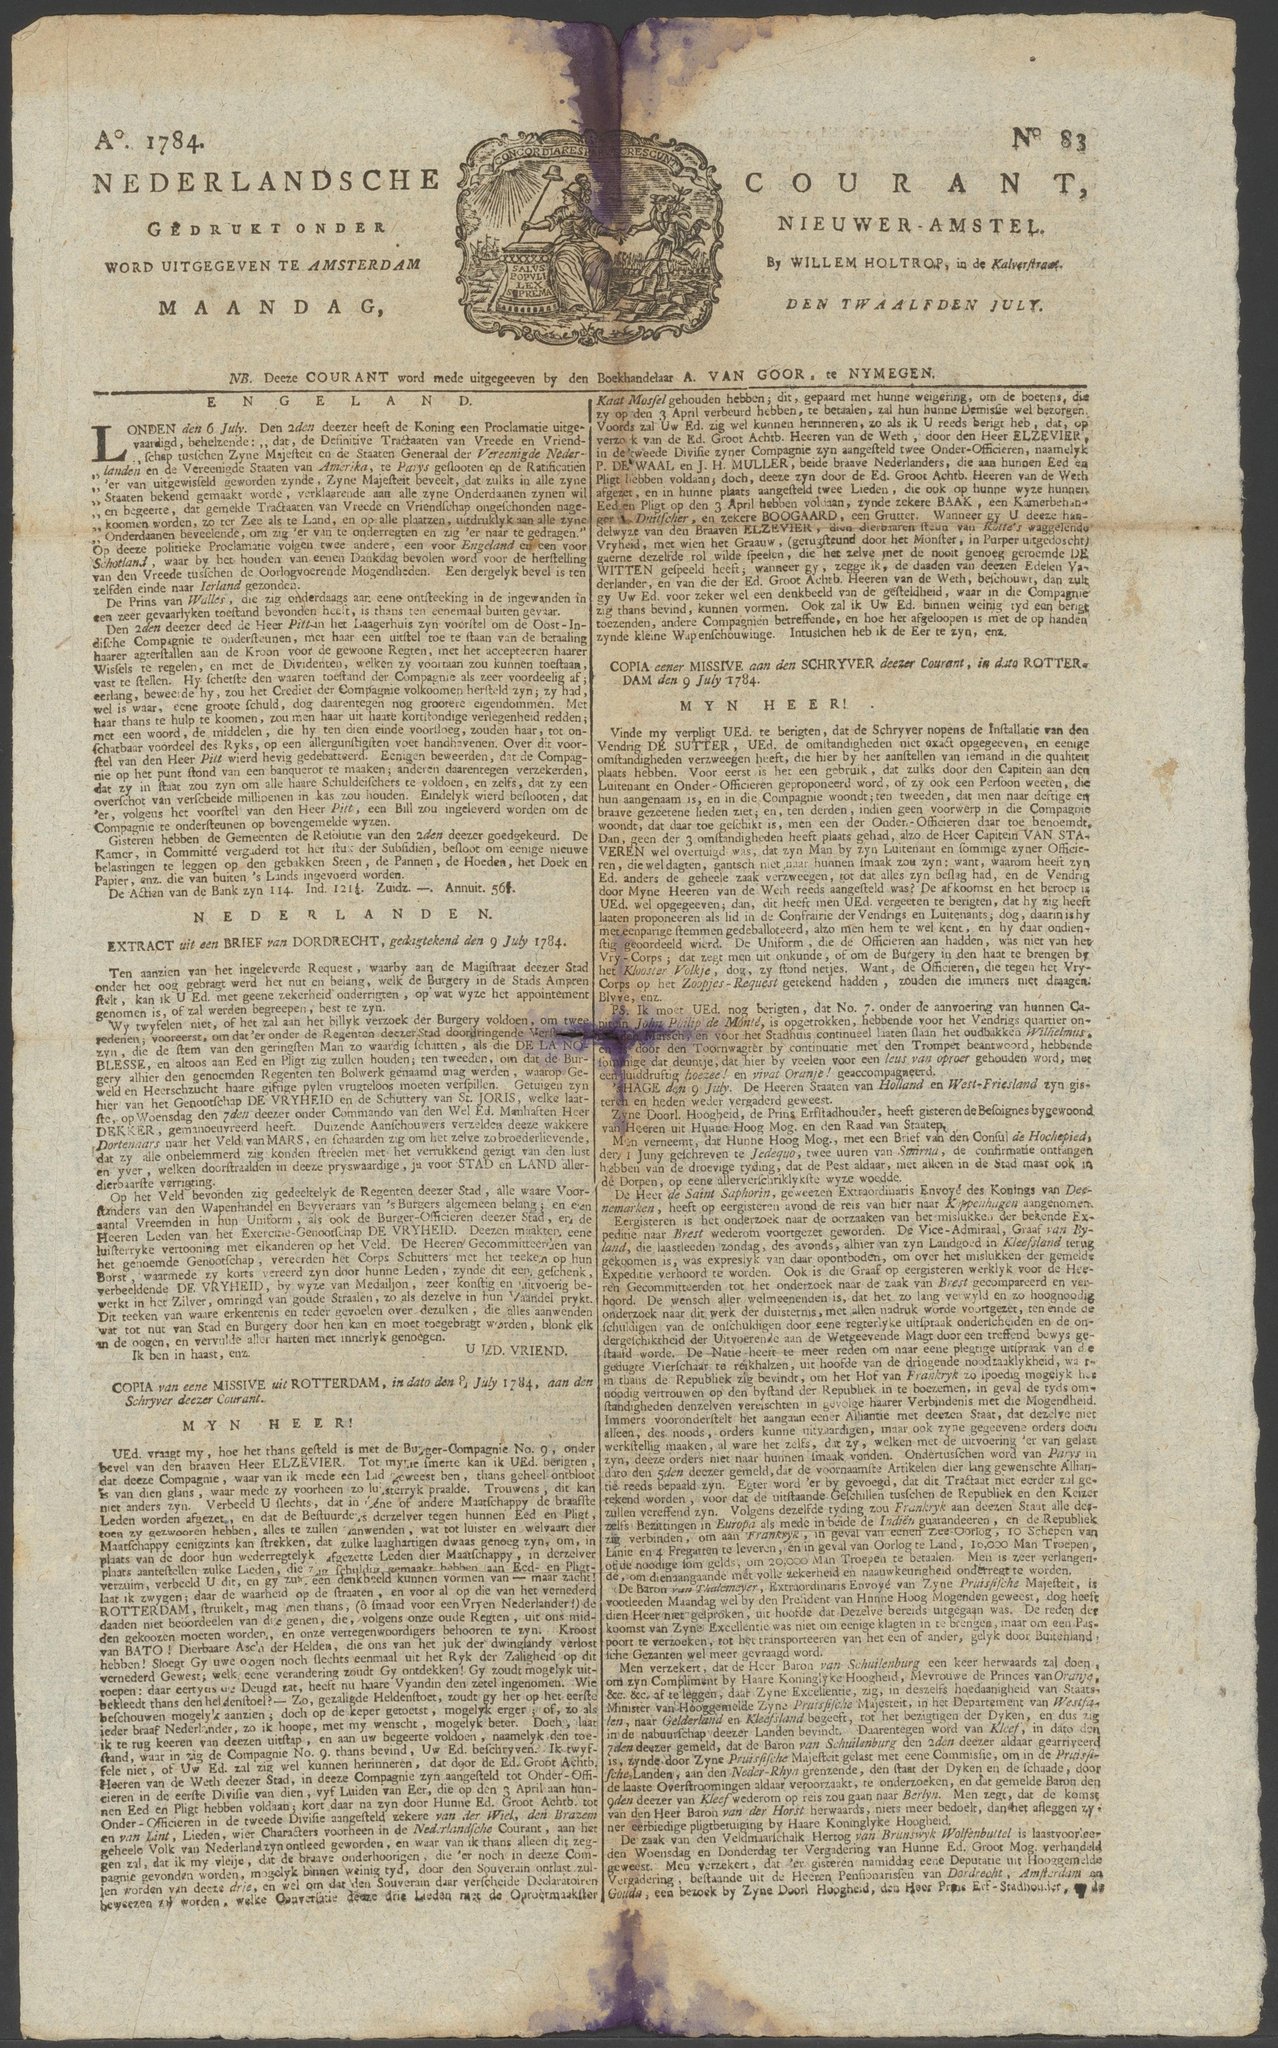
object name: newspaper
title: Nederlandsche Courant, 12 juli 1784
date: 1784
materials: paper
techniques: letterpress printing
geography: nieuwer-amstel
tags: newspaper, news-sheet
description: Exemplaar van de krant 'Nederlandsche Courant' van 12 juli 1784. Enkelbladig, beide zijden bedrukt. Bovenaan een vignet met de Vrijheid en Mercurius. Onderwerpsrubrieken binnen de Atlas Zeden en Gewoonten: Regeering, Officieele Nieuwsbladen.